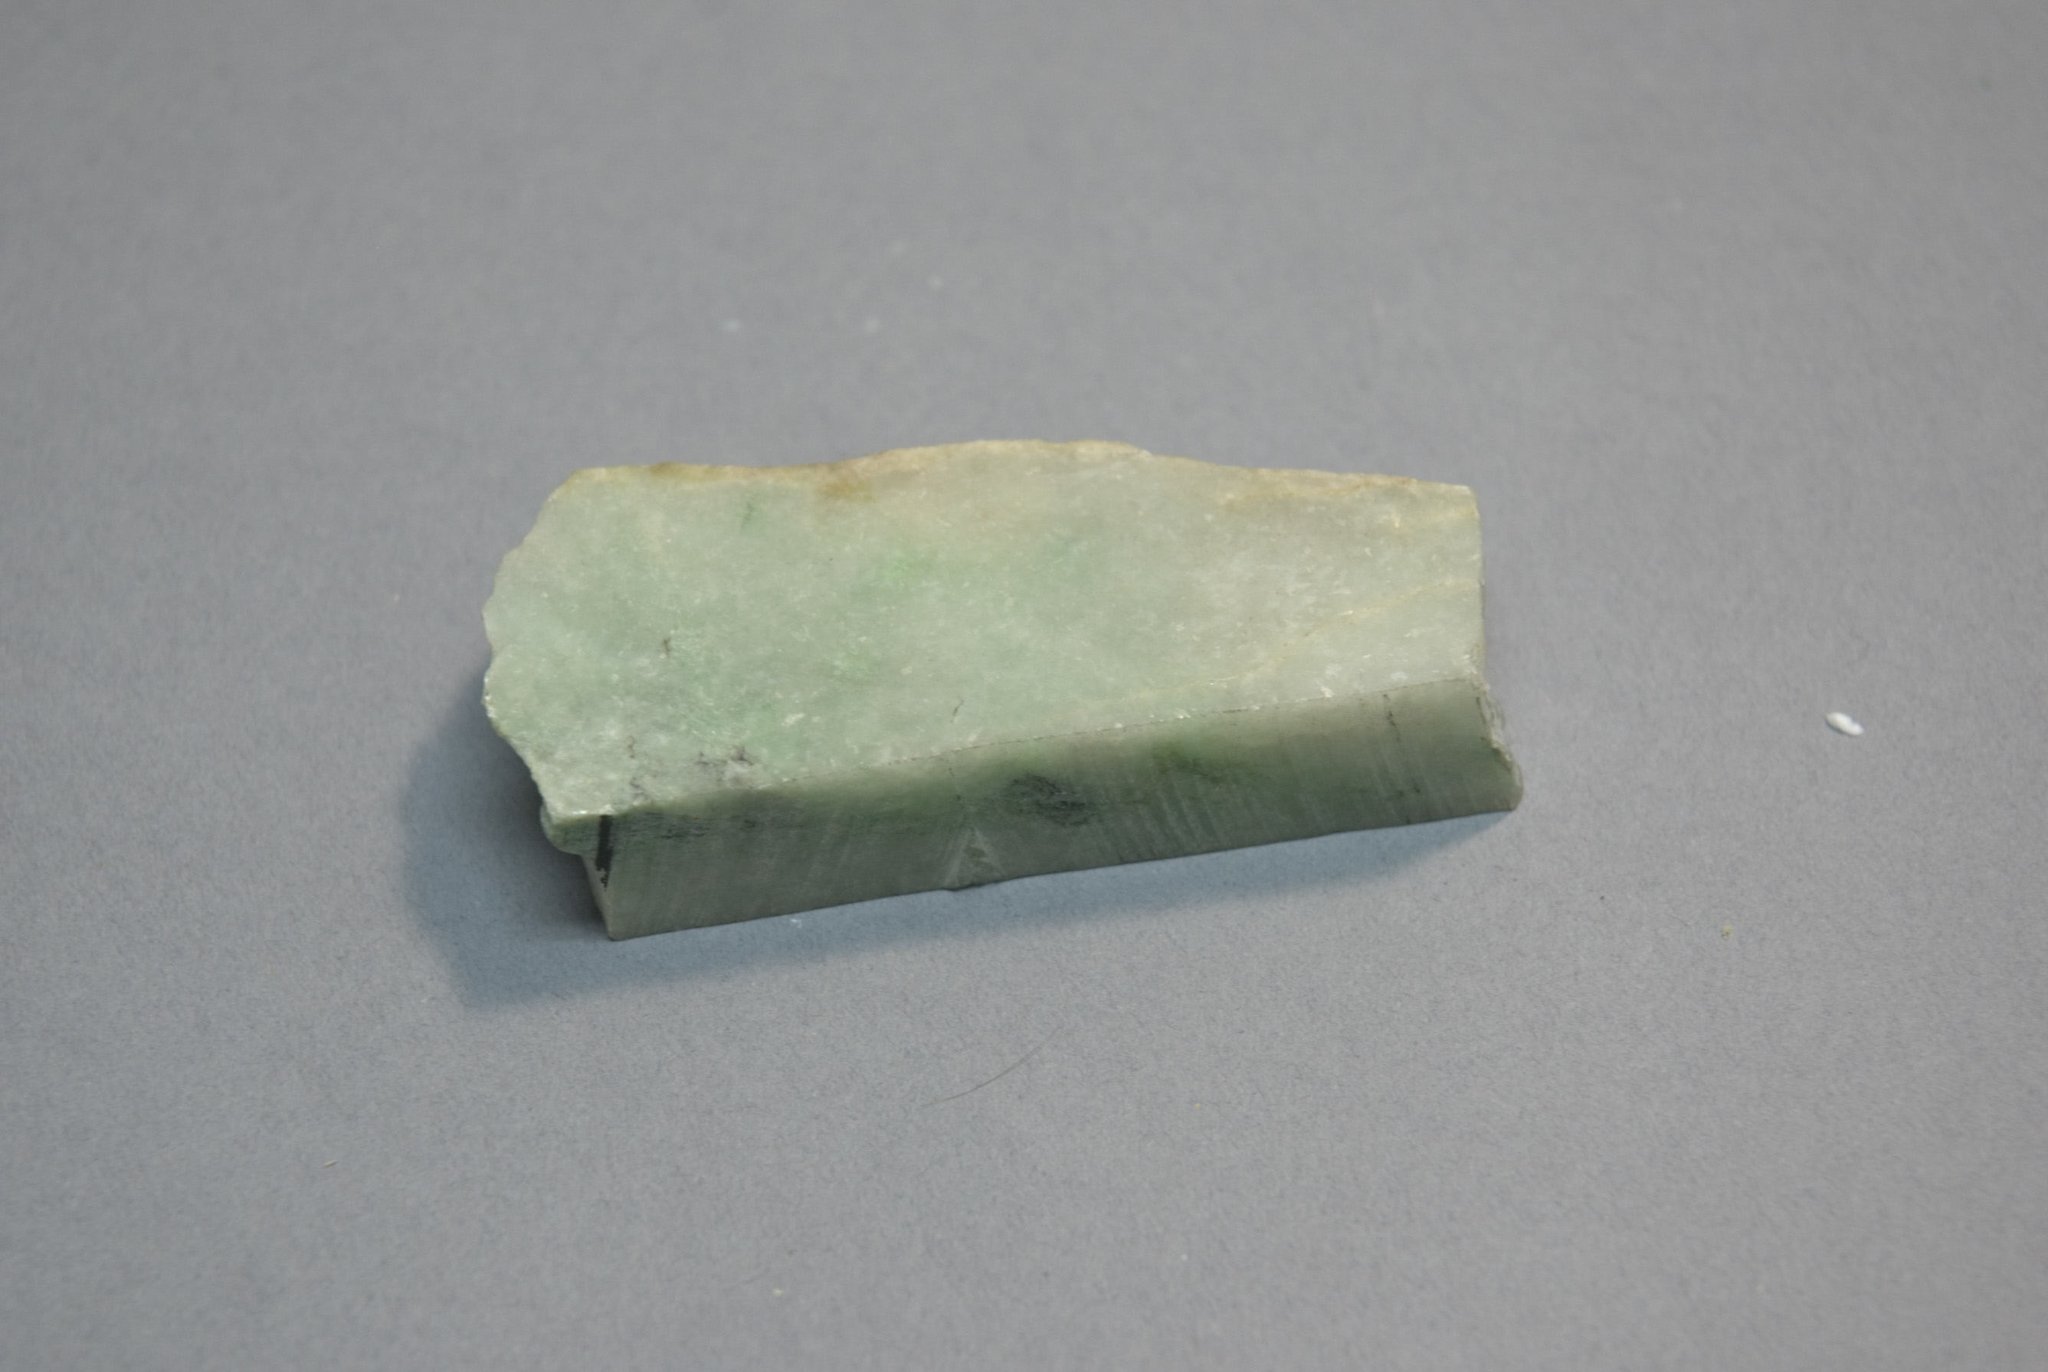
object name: jade carving material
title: Sample of Japanese Jadeite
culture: chinese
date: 1901-2000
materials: jade